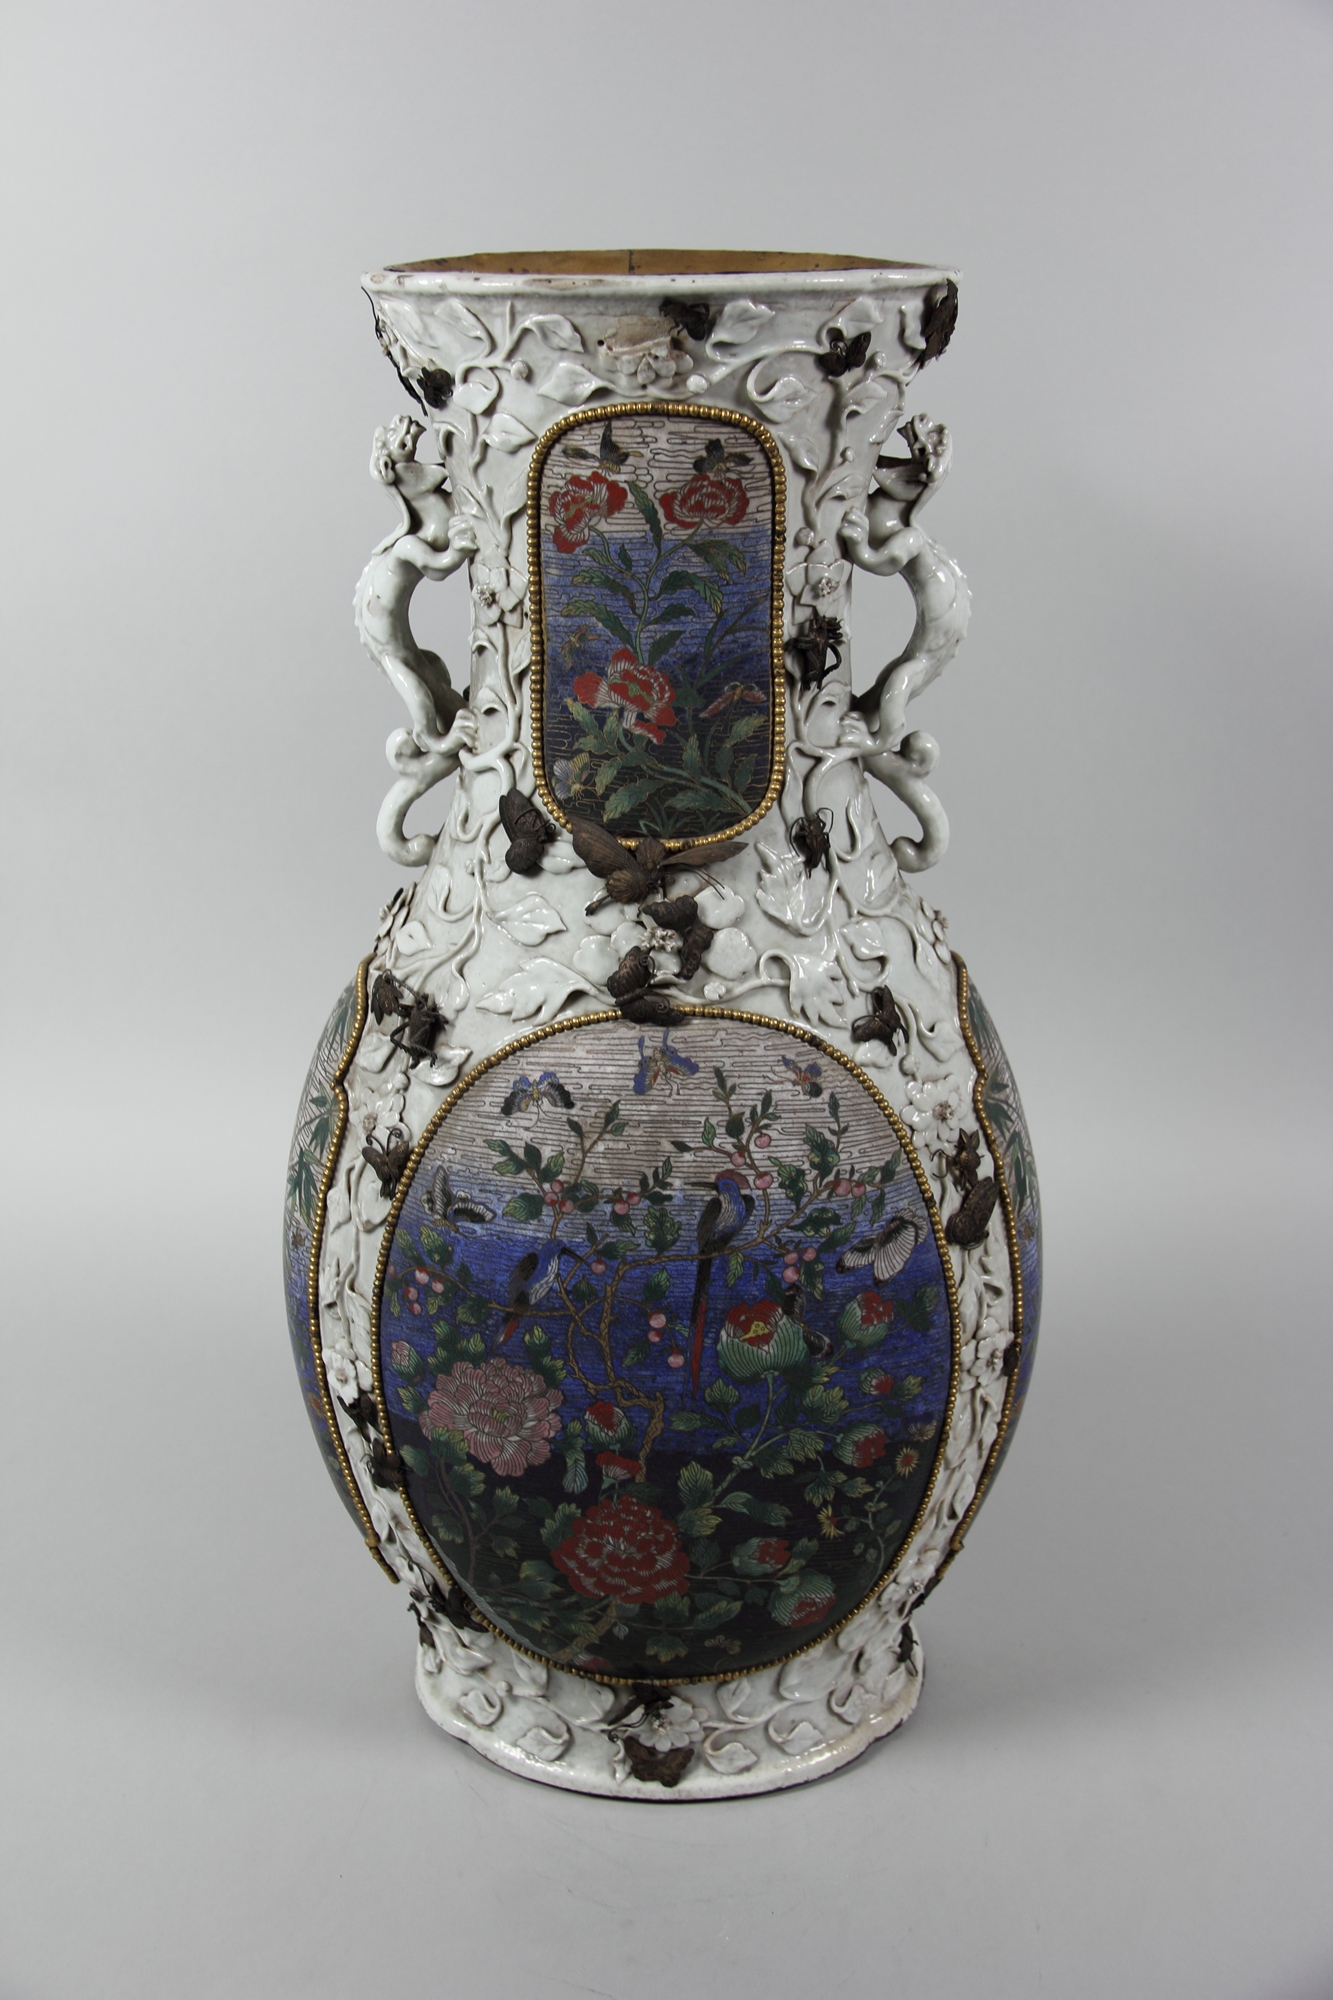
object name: vase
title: Vase with birds and flowers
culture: chinese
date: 1801-1900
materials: copper alloy, enamel, panel, porcelain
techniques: inlay, relief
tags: birds,flowers,plants